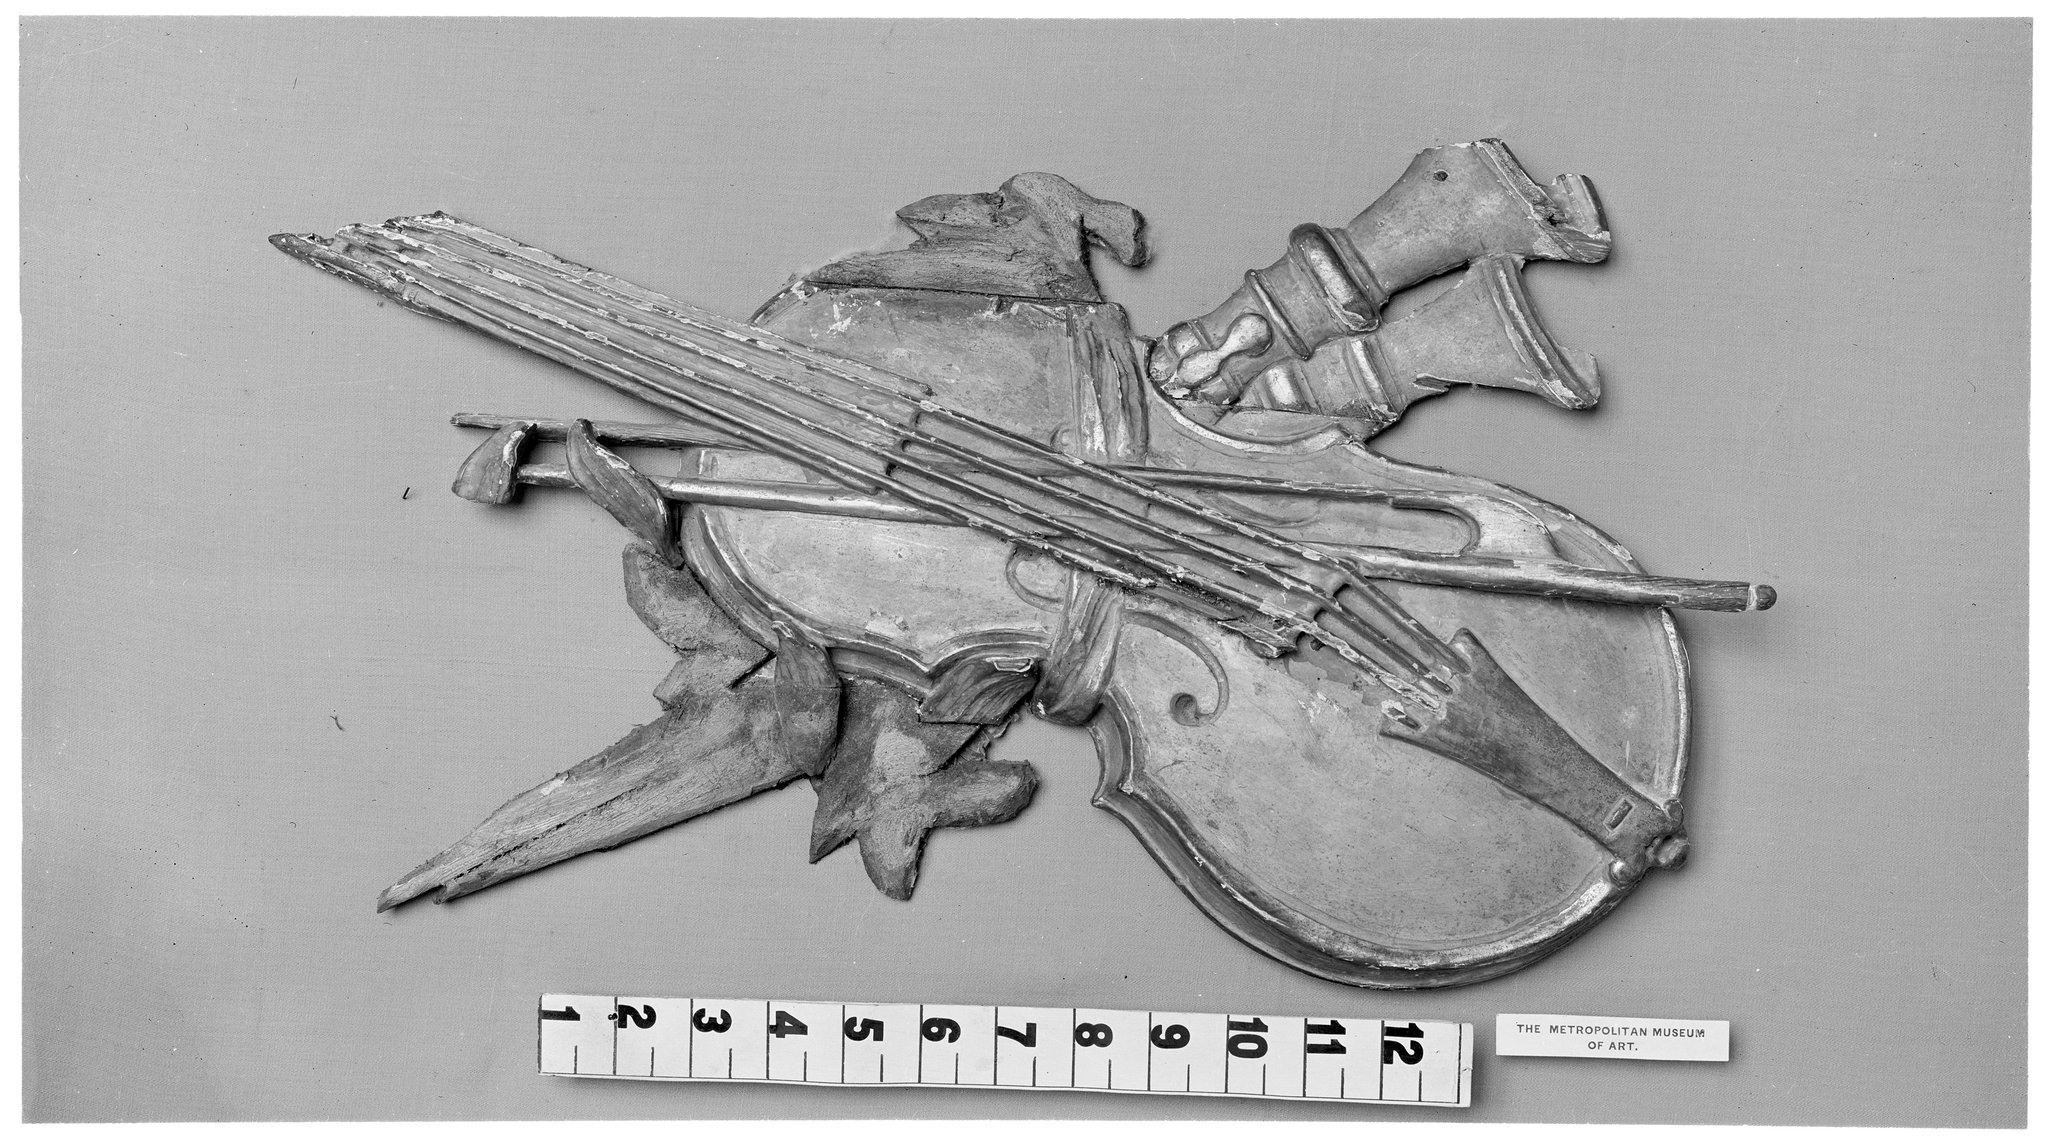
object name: trophy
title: Trophy of musical instruments detail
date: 1701-1800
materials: gilt, wood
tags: violins,trophies